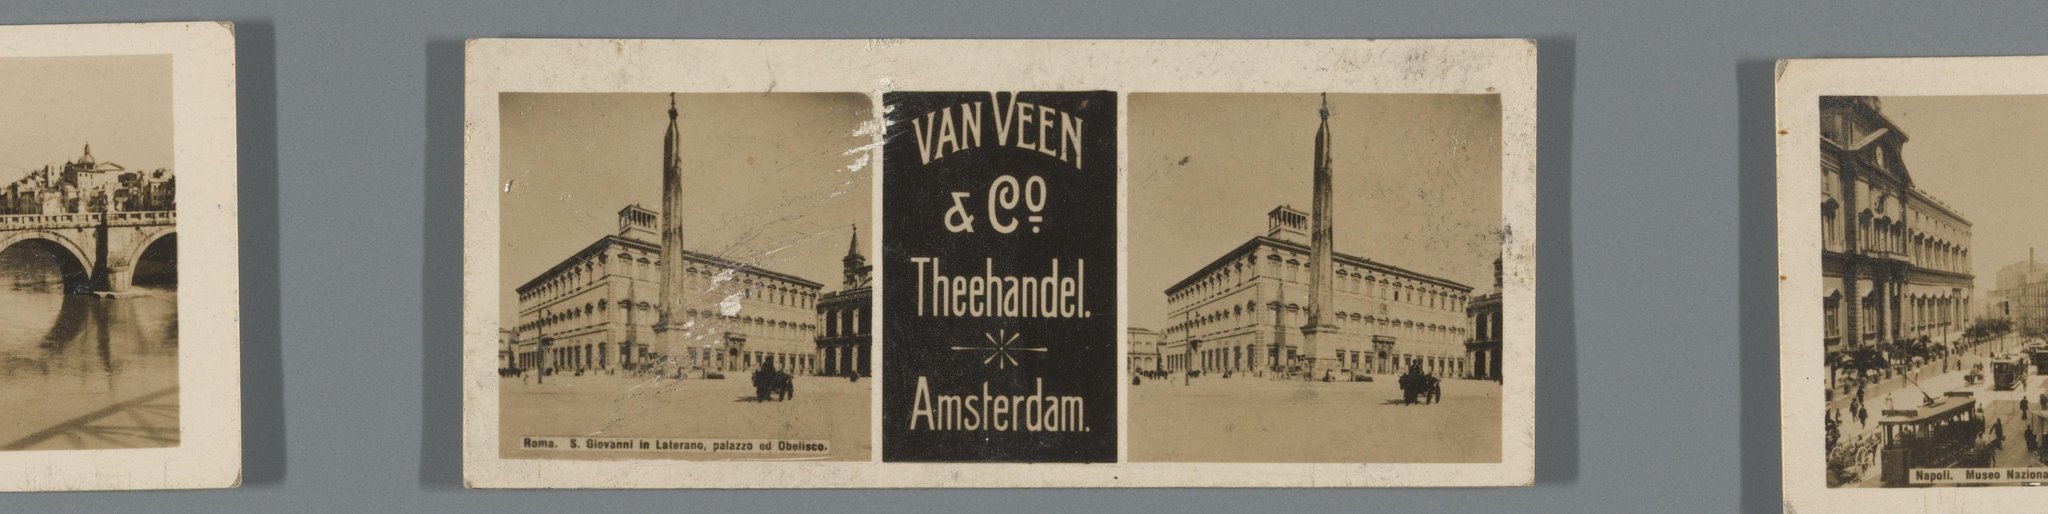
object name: stereograph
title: Roma, S. Giovanni in Laterano, palazzo ed Obelisco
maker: Anonymous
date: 1910-1920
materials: paper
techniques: gelatin silver print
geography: rome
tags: church (exterior)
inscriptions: inscription: ‘Stereoscopen voor deze plaatjes/ zijn verkrijgbaar à 25 cents per stuk/ bij VAN VEEN & Co., Amsterdam,/ Rotterdam, Den Haag, Nijmegen/ Haarlem en Hilversum.’